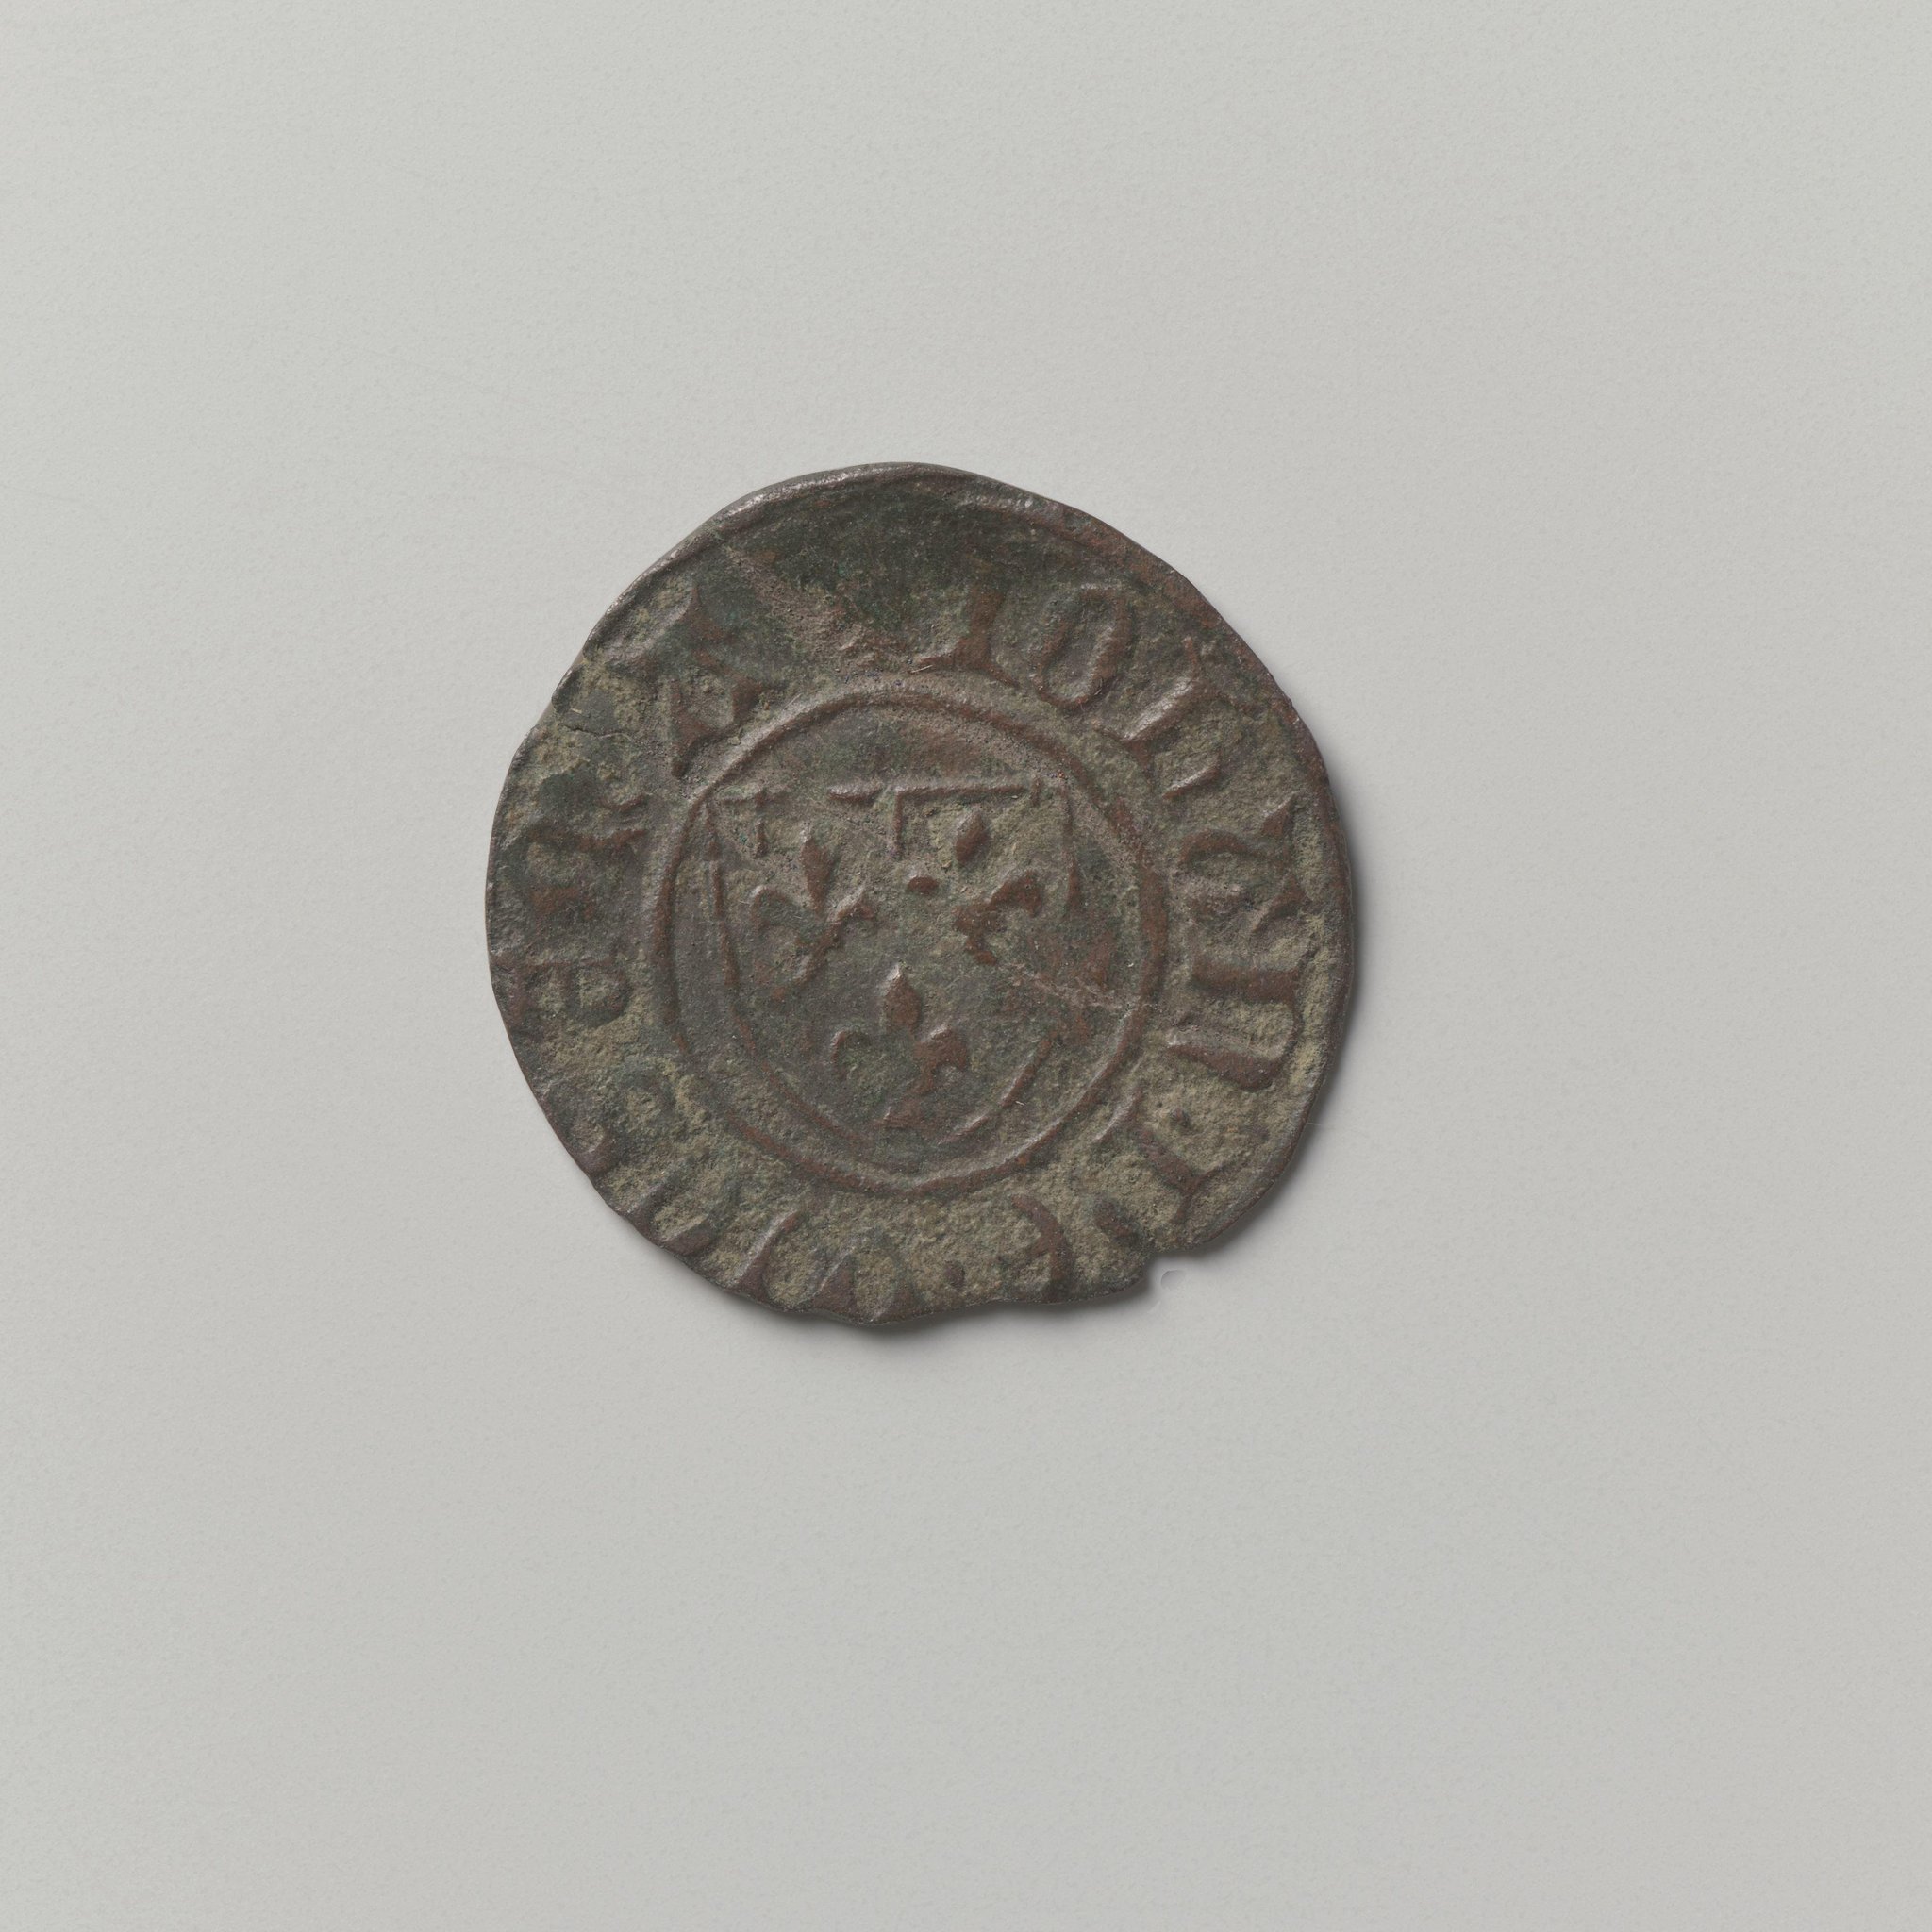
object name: coin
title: Dubbele mijt uit Rummen van Jan van Wezemaal, 1427-1435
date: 1427-1435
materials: silver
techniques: striking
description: Zilveren munt. Voorzijde: wapenschild. Keerzijde: kort gevoet kruis.